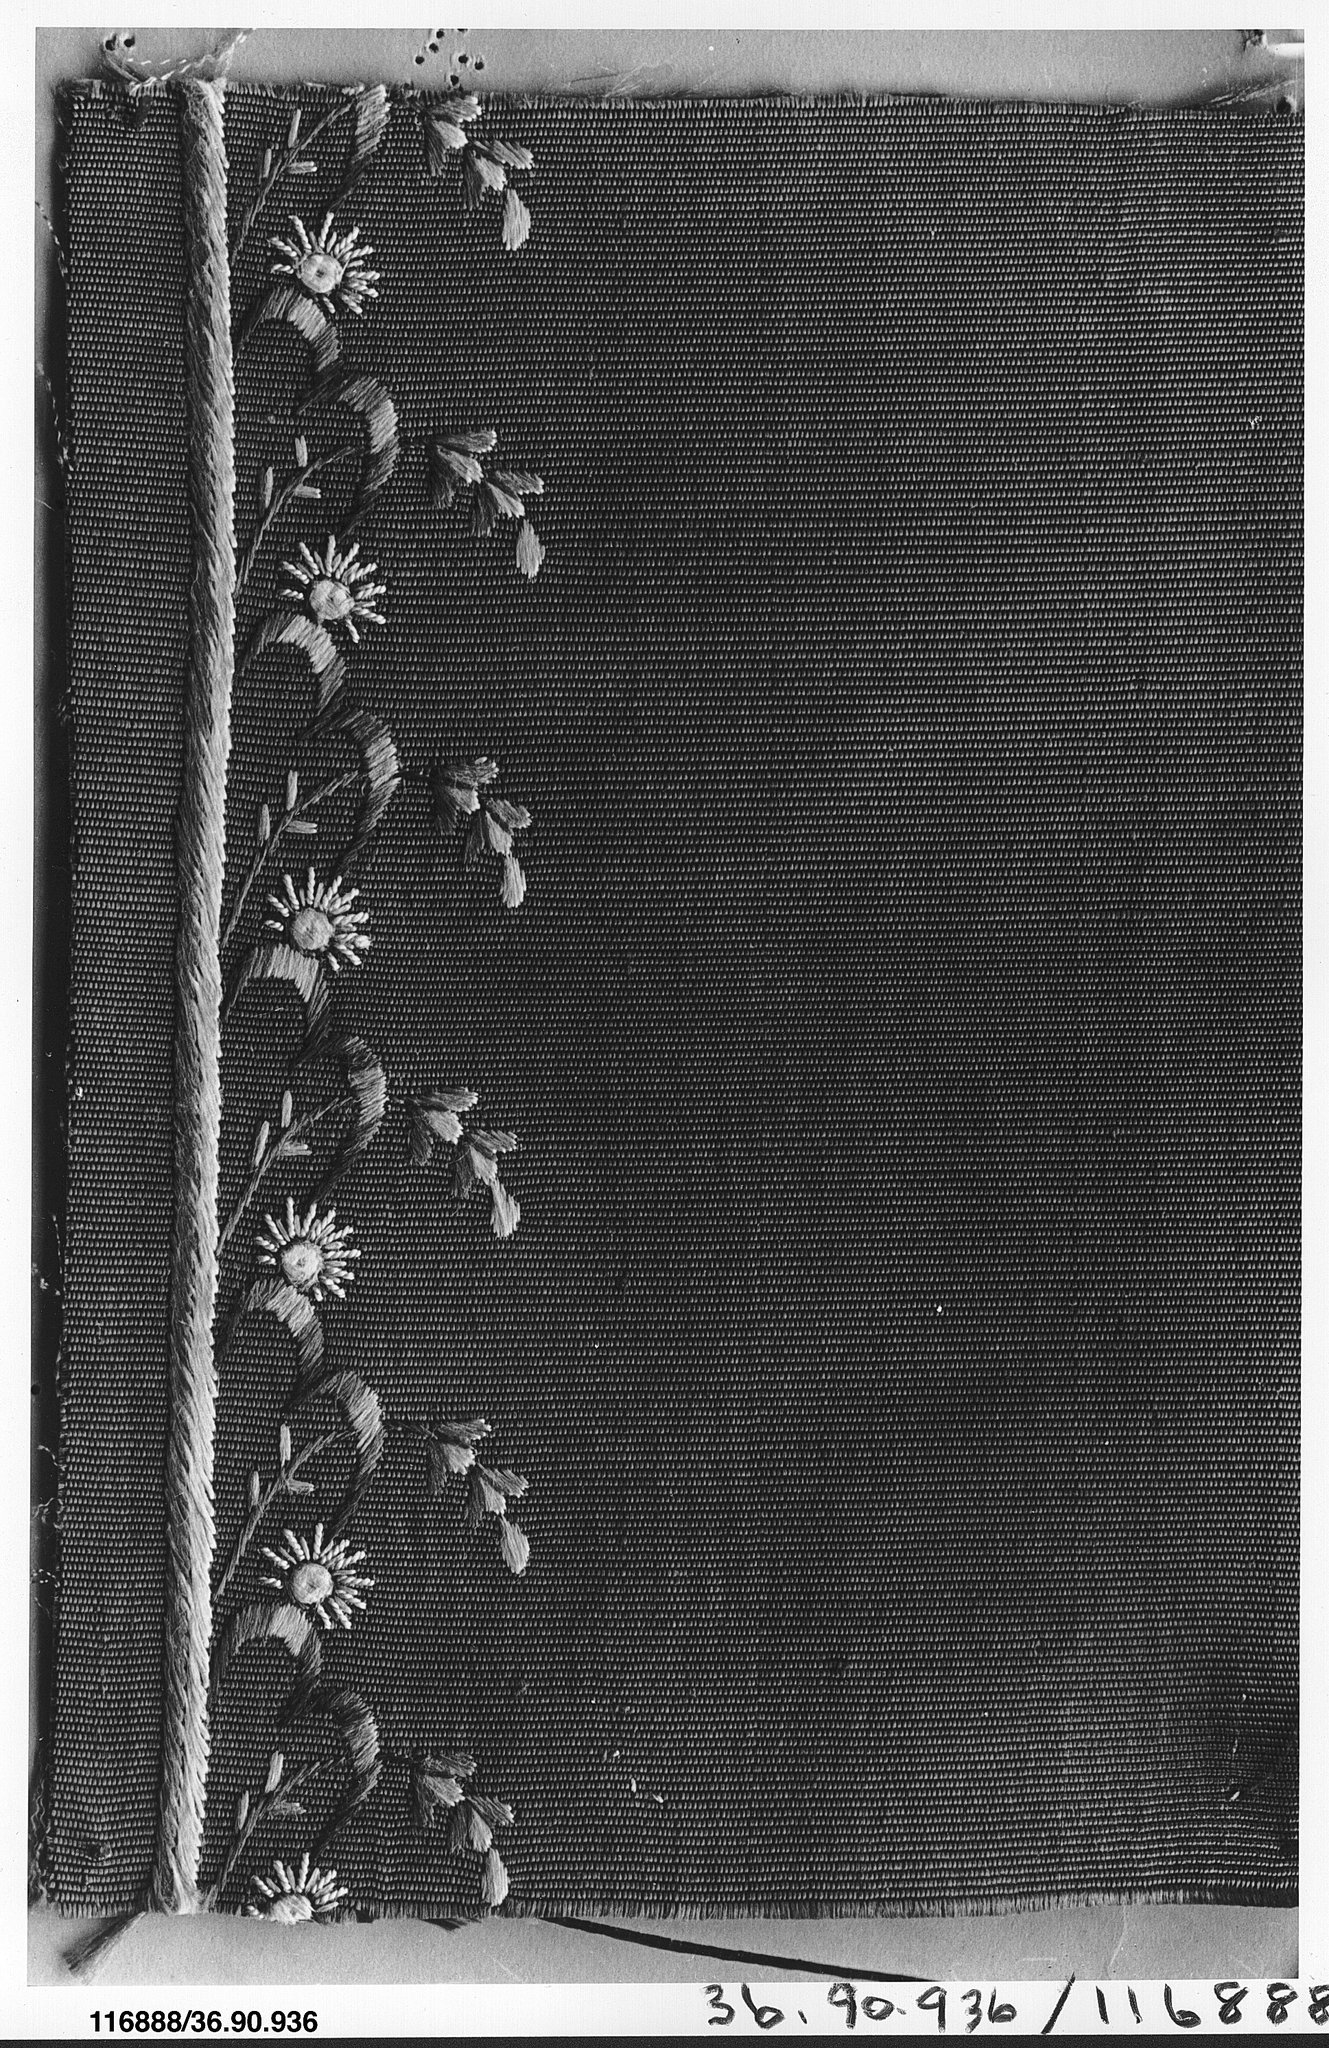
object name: sample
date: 1801-1833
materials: silk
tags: flowers